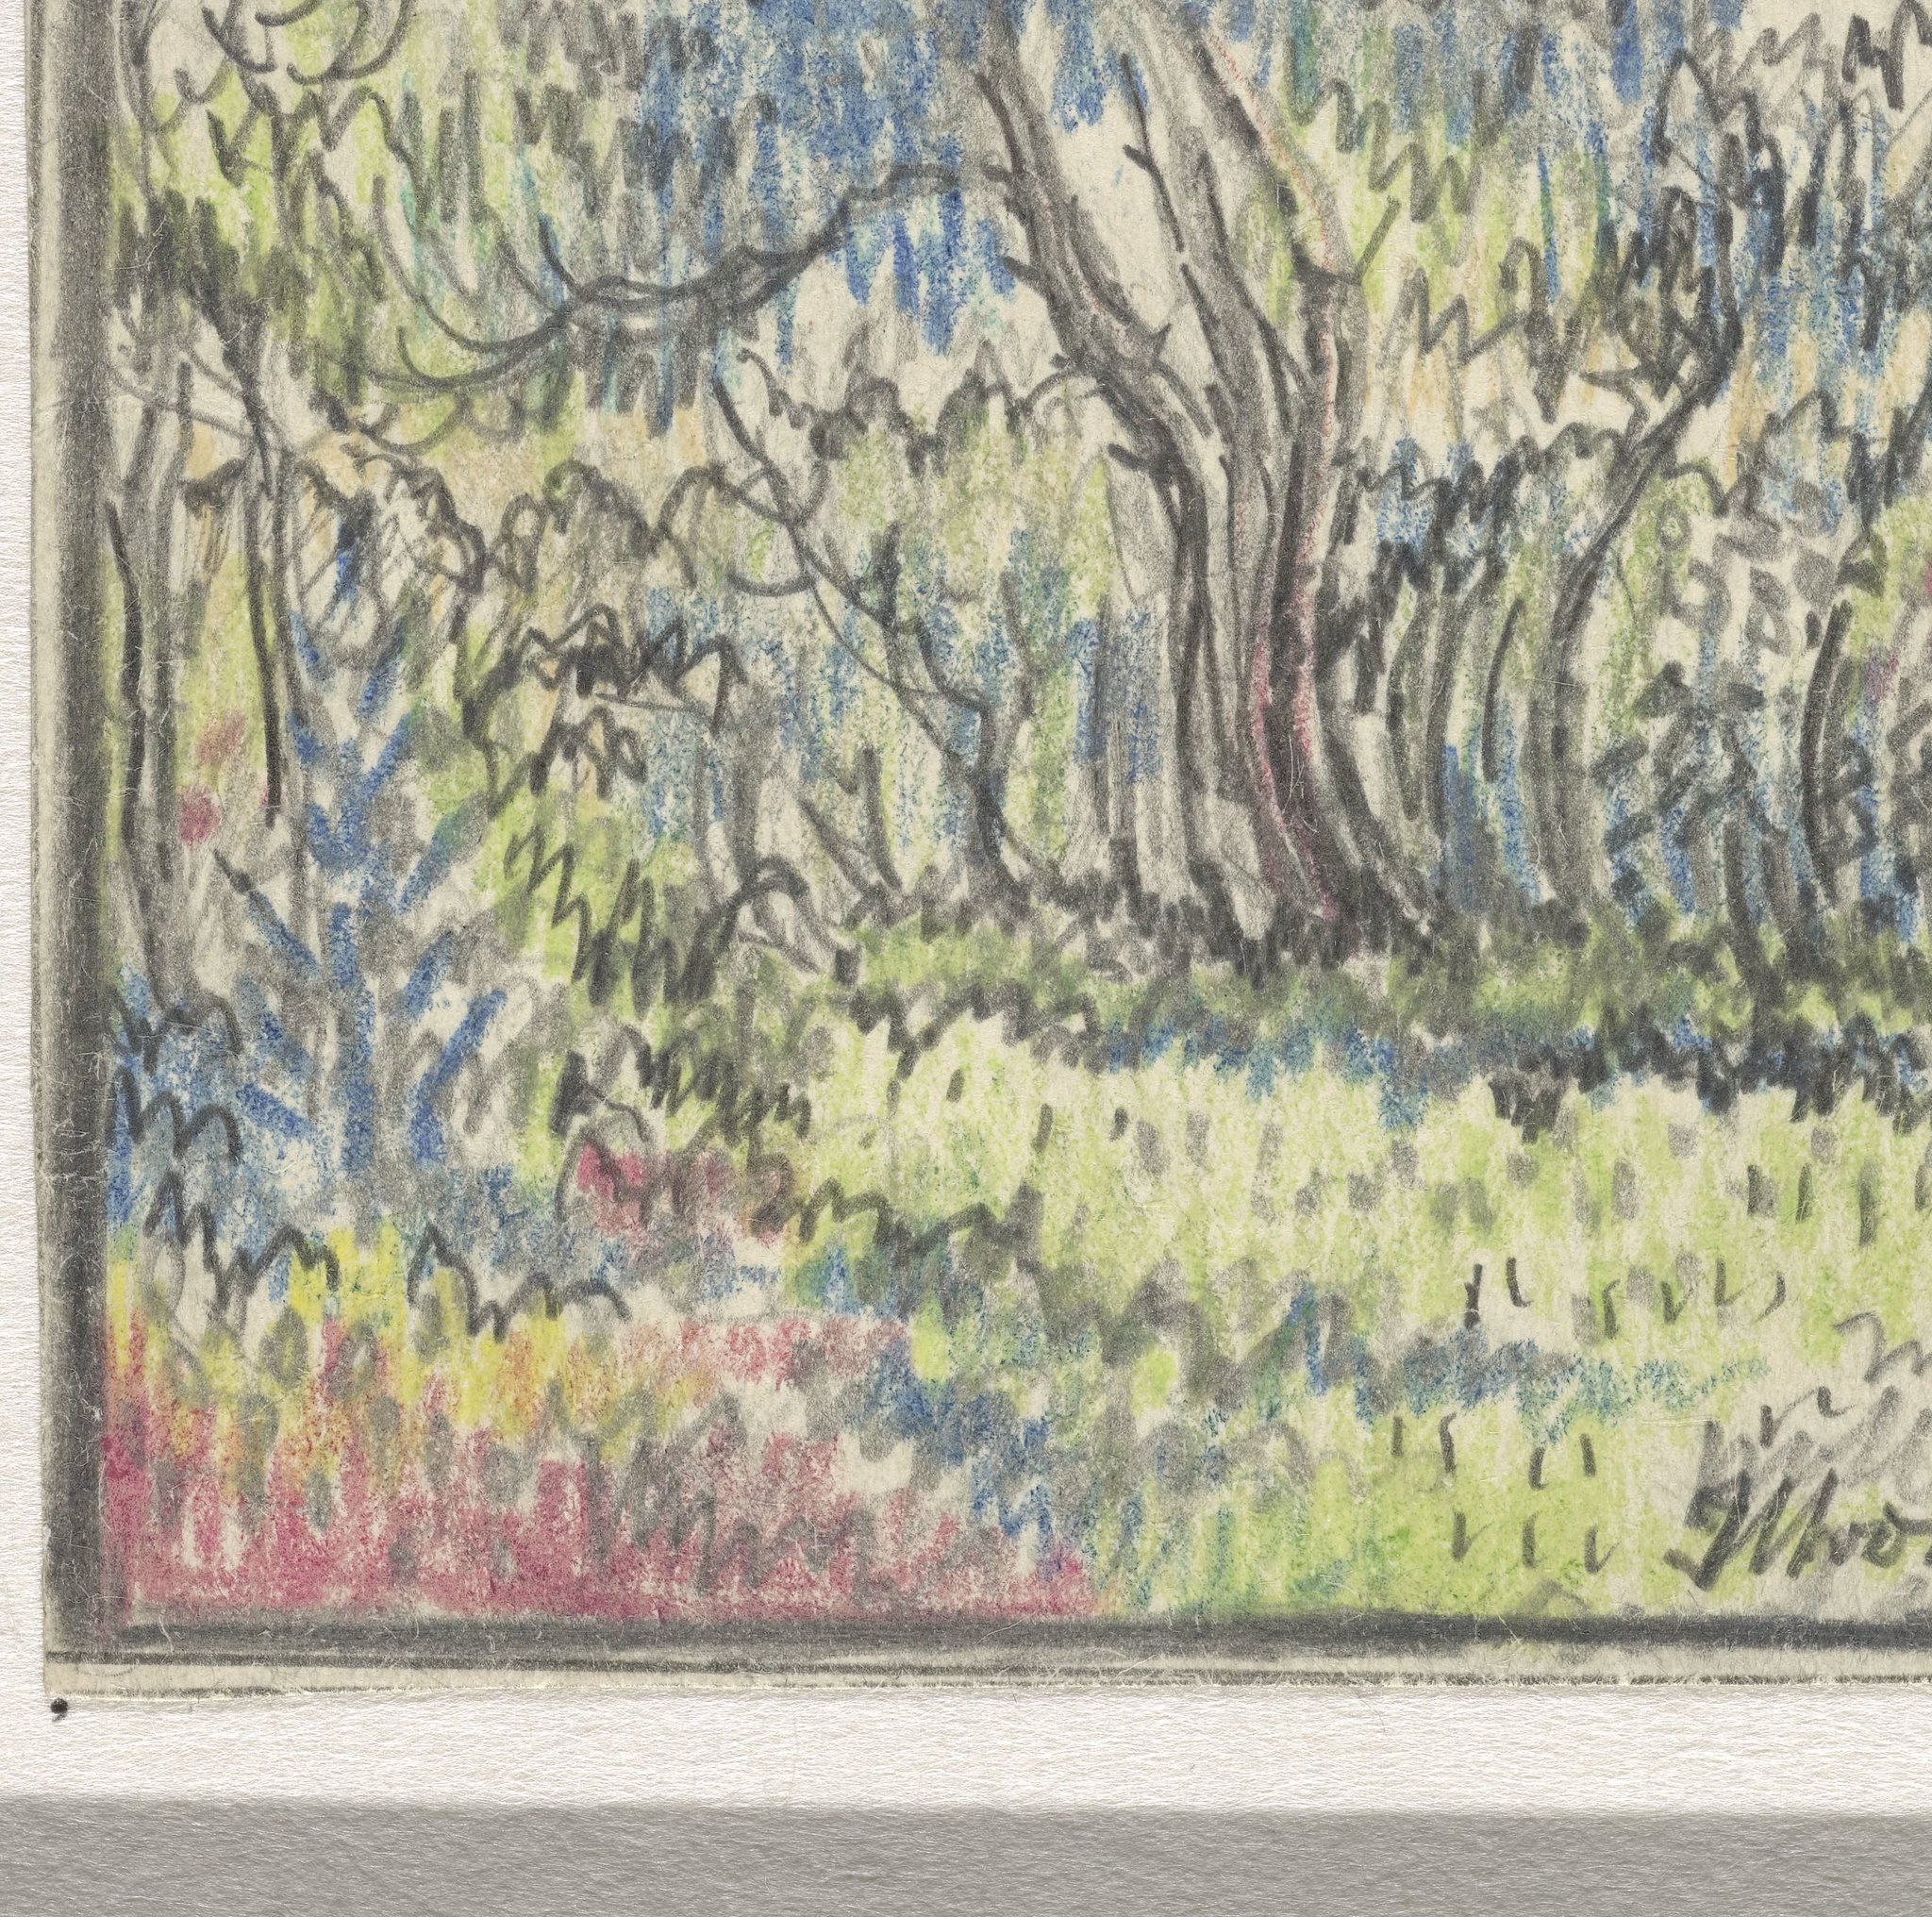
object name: drawing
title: Tuin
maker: herman antonius van daalhoff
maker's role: draughtsman, print maker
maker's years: 1867-1953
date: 1935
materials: paper, pastel, pencil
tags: garden